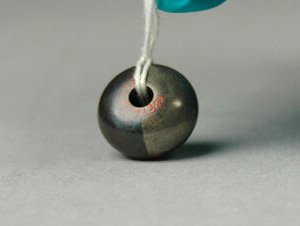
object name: ojime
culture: japanese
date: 1801-1900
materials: alloy, metal